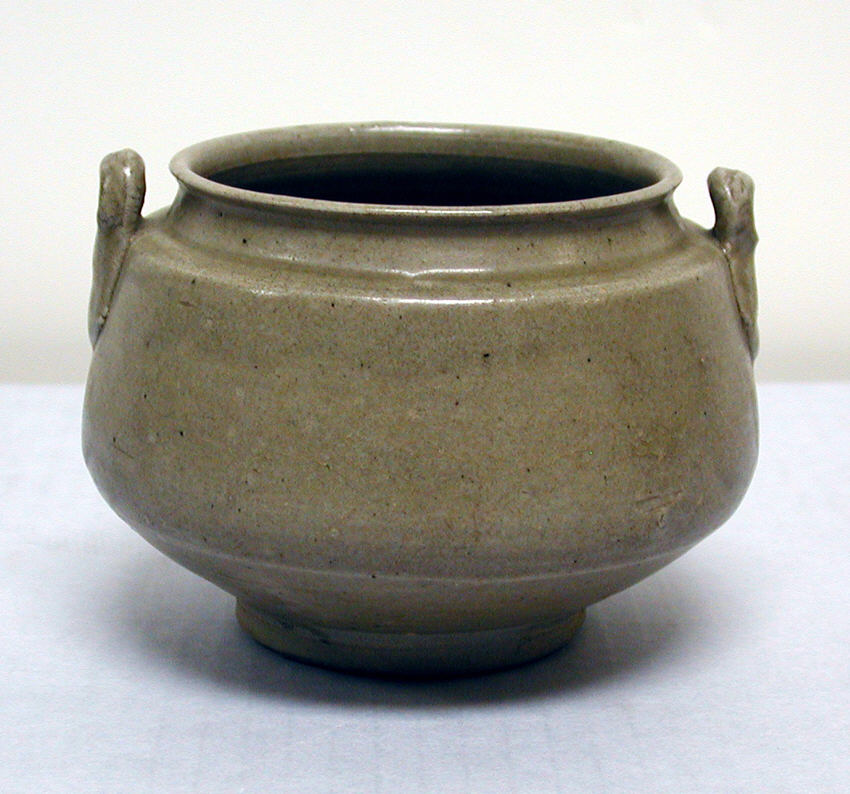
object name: jar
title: Jar with loop handles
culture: chinese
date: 618-907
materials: glaze, stoneware